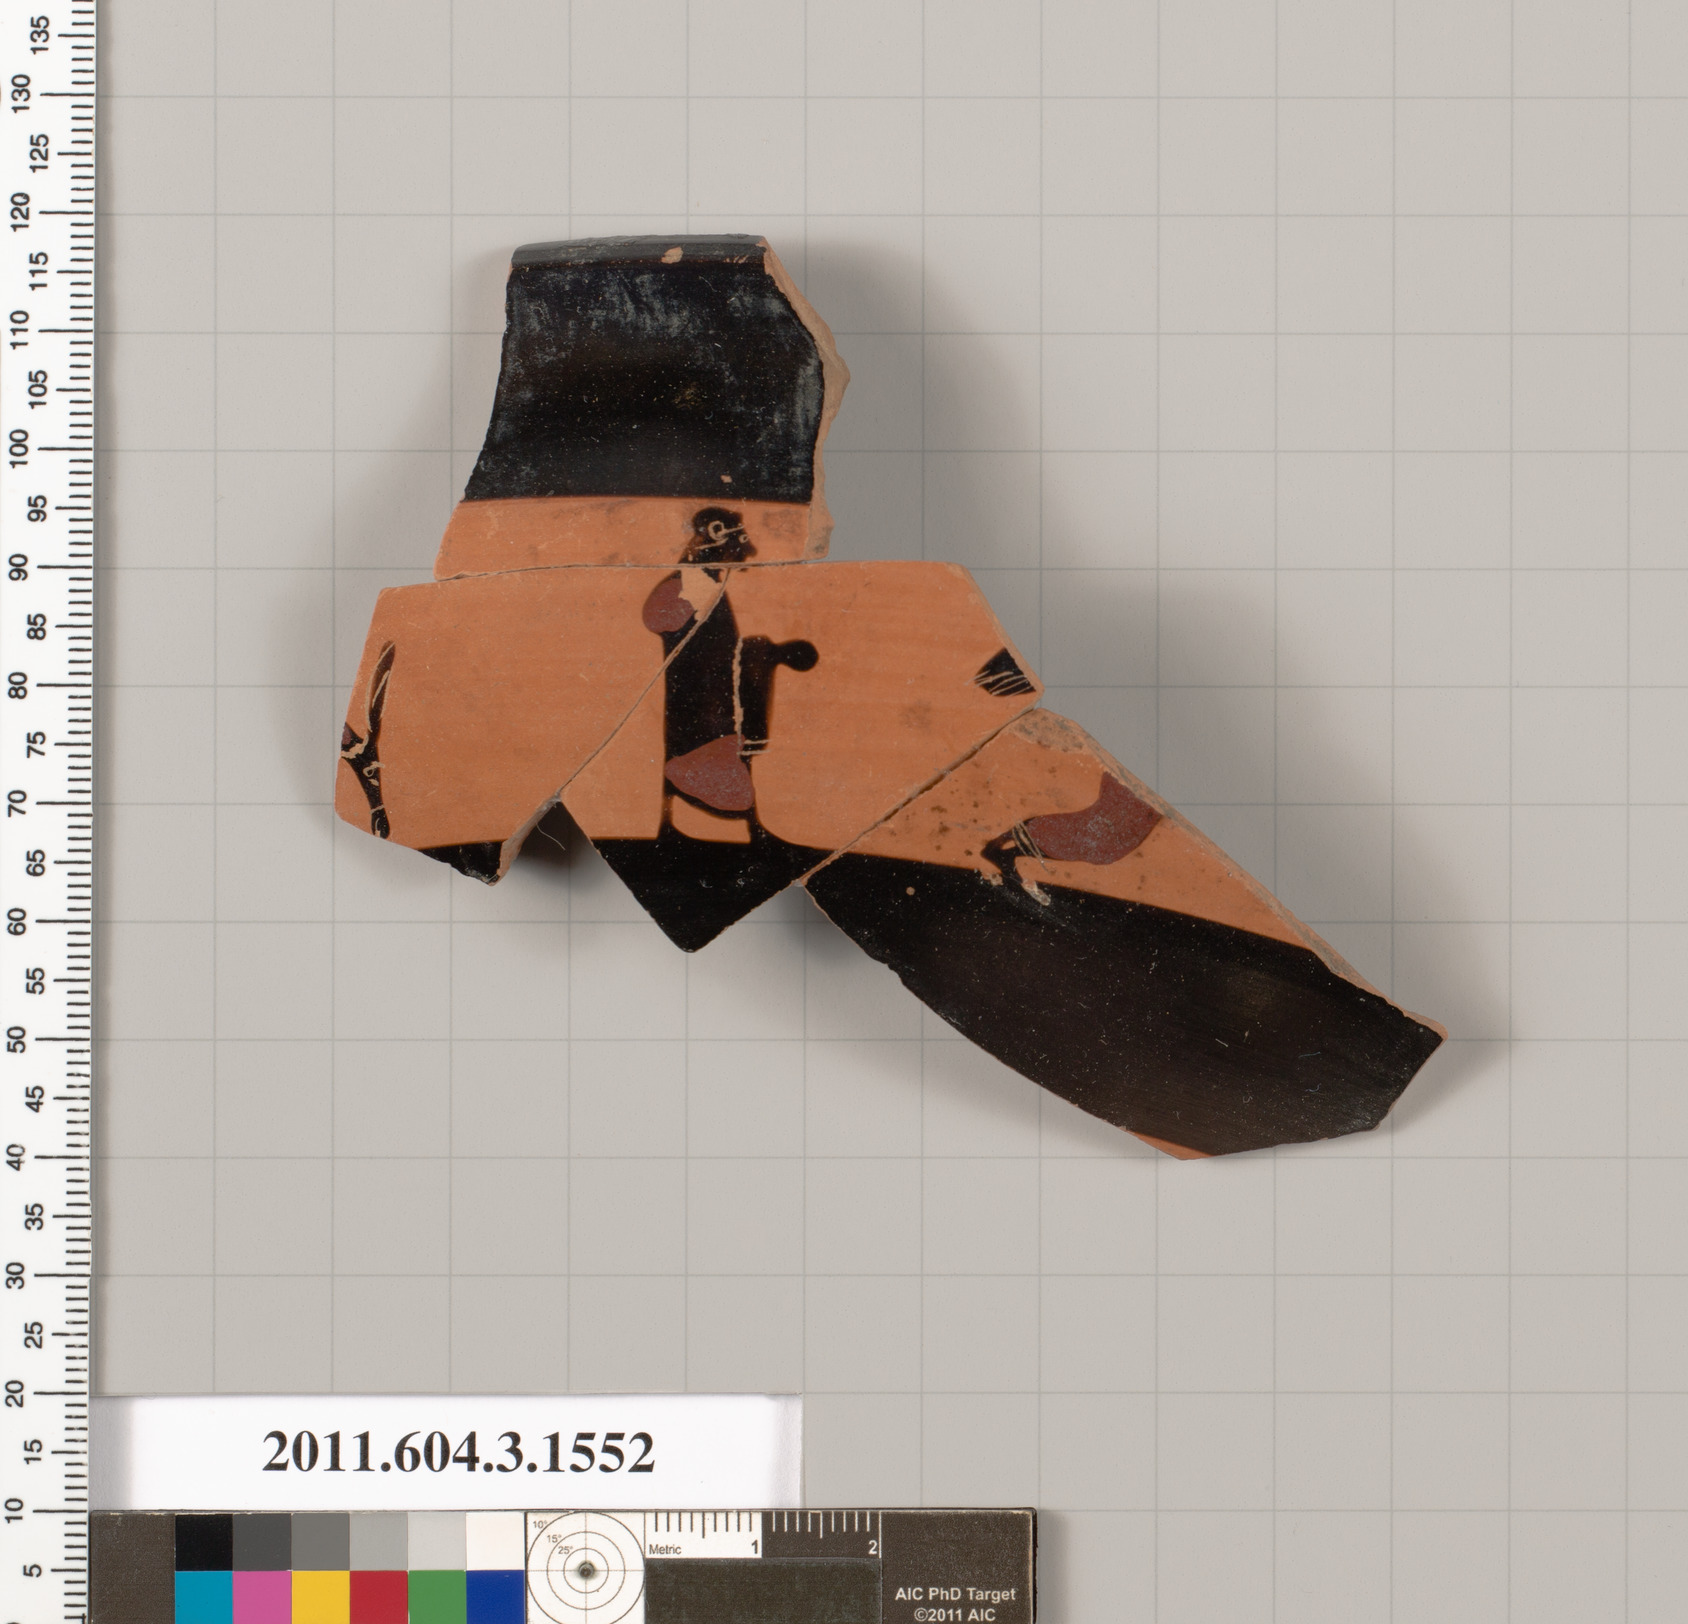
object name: kylix fragment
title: Terracotta rim fragment of a kylix: Band cup (drinking cup)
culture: greek, attic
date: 560-550 BCE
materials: terracotta